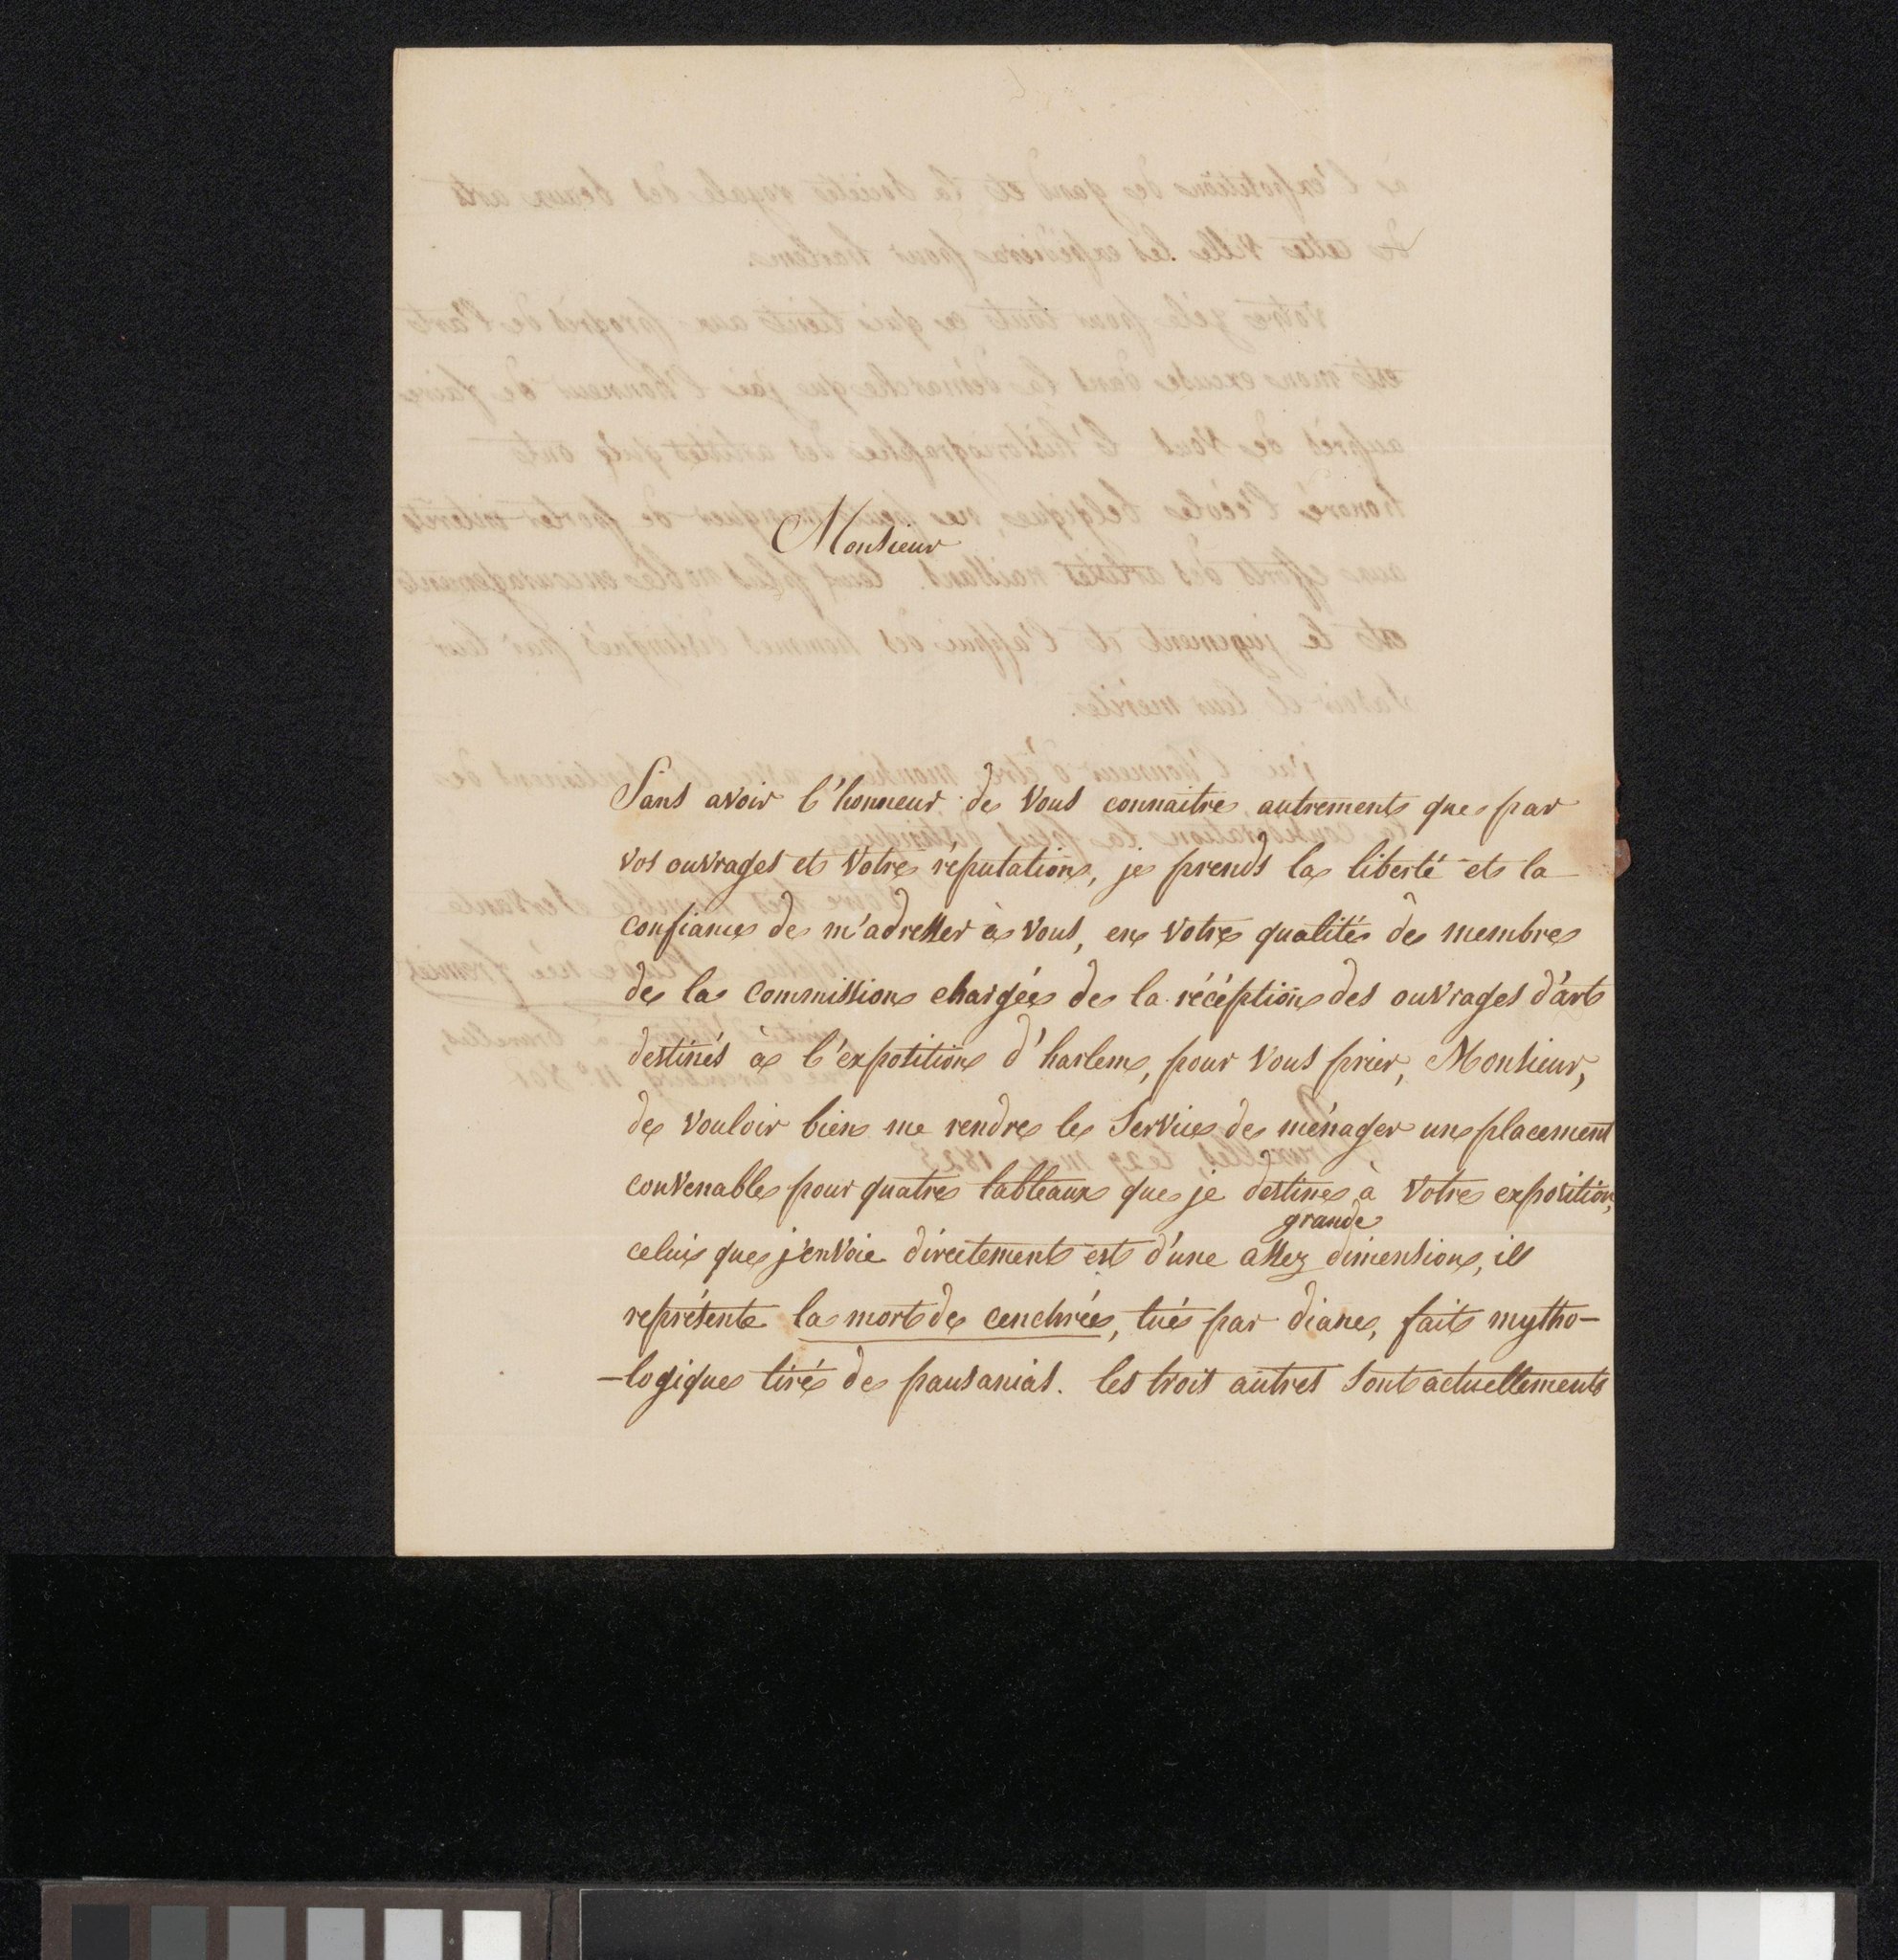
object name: letter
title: Brief aan Adriaan van der Willigen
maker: sophie rude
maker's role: painter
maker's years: 1797-1867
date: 1825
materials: ink, paper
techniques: pen, writing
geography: brussels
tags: haarlem, adriaan van der willigen, painting (including book-illumination, miniature-painting), exhibition ~ art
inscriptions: watermark, seal